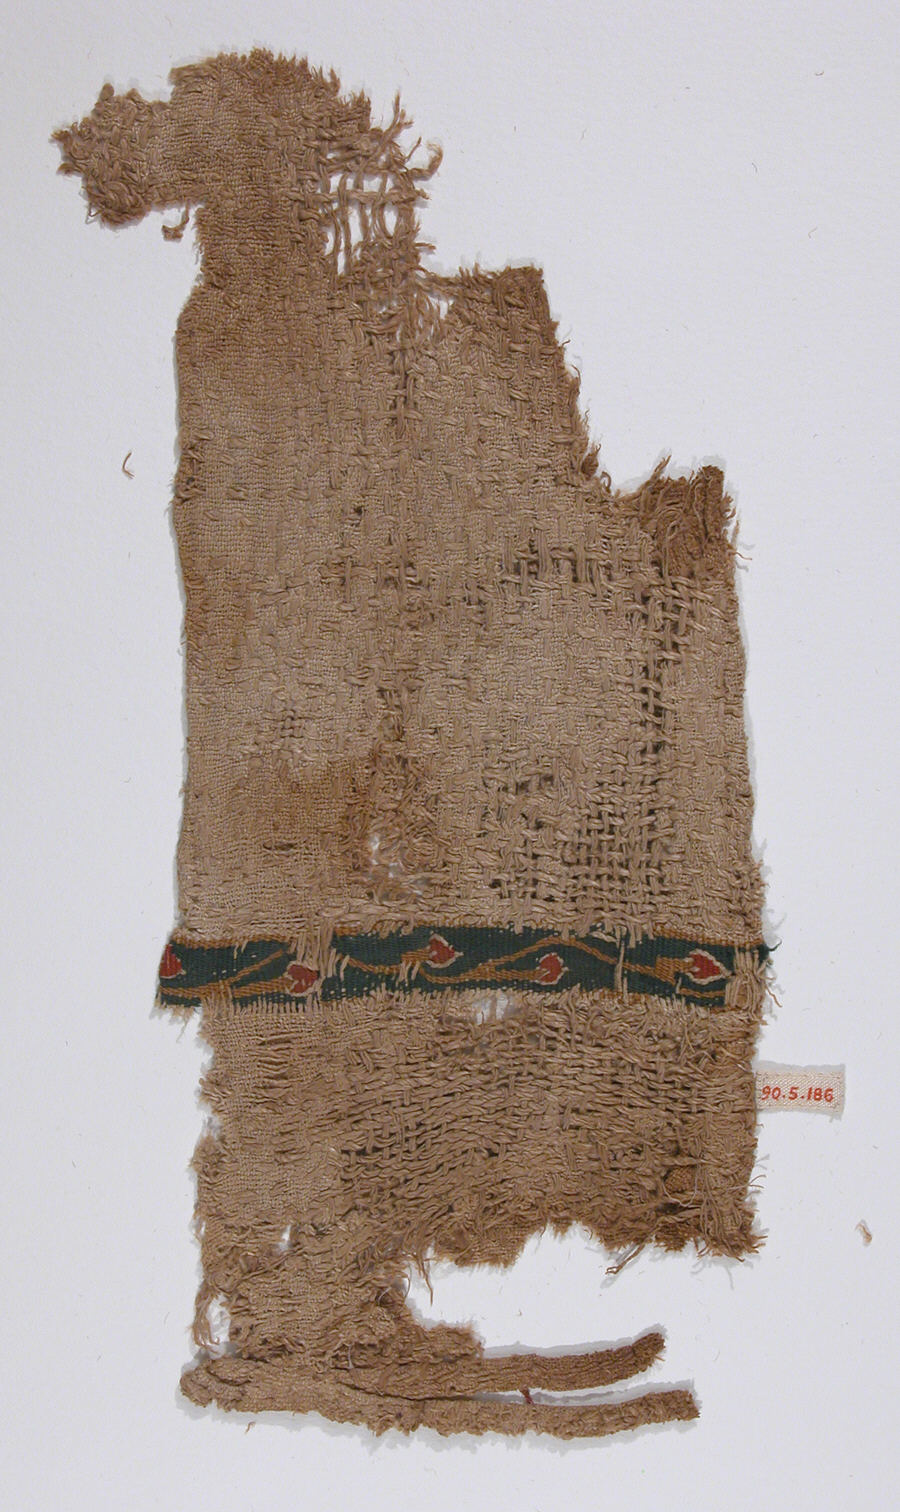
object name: textile fragment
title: Fragment of a Sleeve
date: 401-500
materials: linen, wool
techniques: weave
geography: egypt